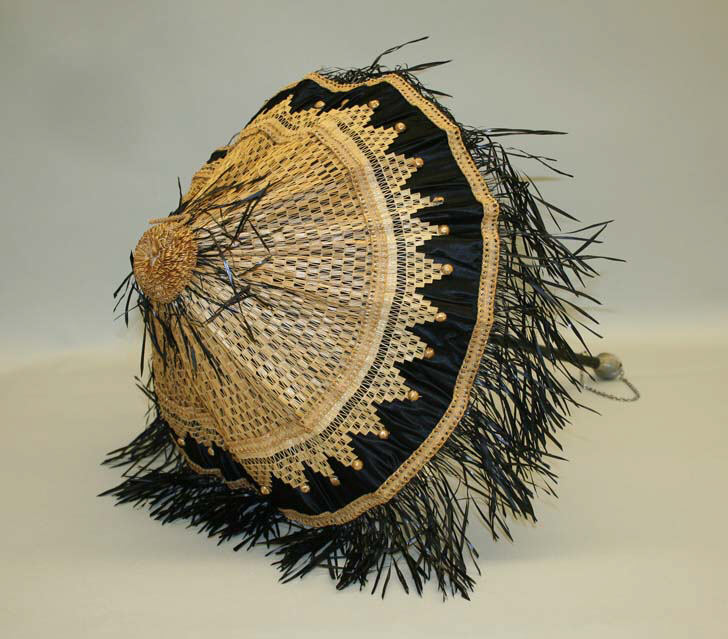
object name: parasol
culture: american or european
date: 1860-1869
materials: raffia, silk, silver, fiber, wood